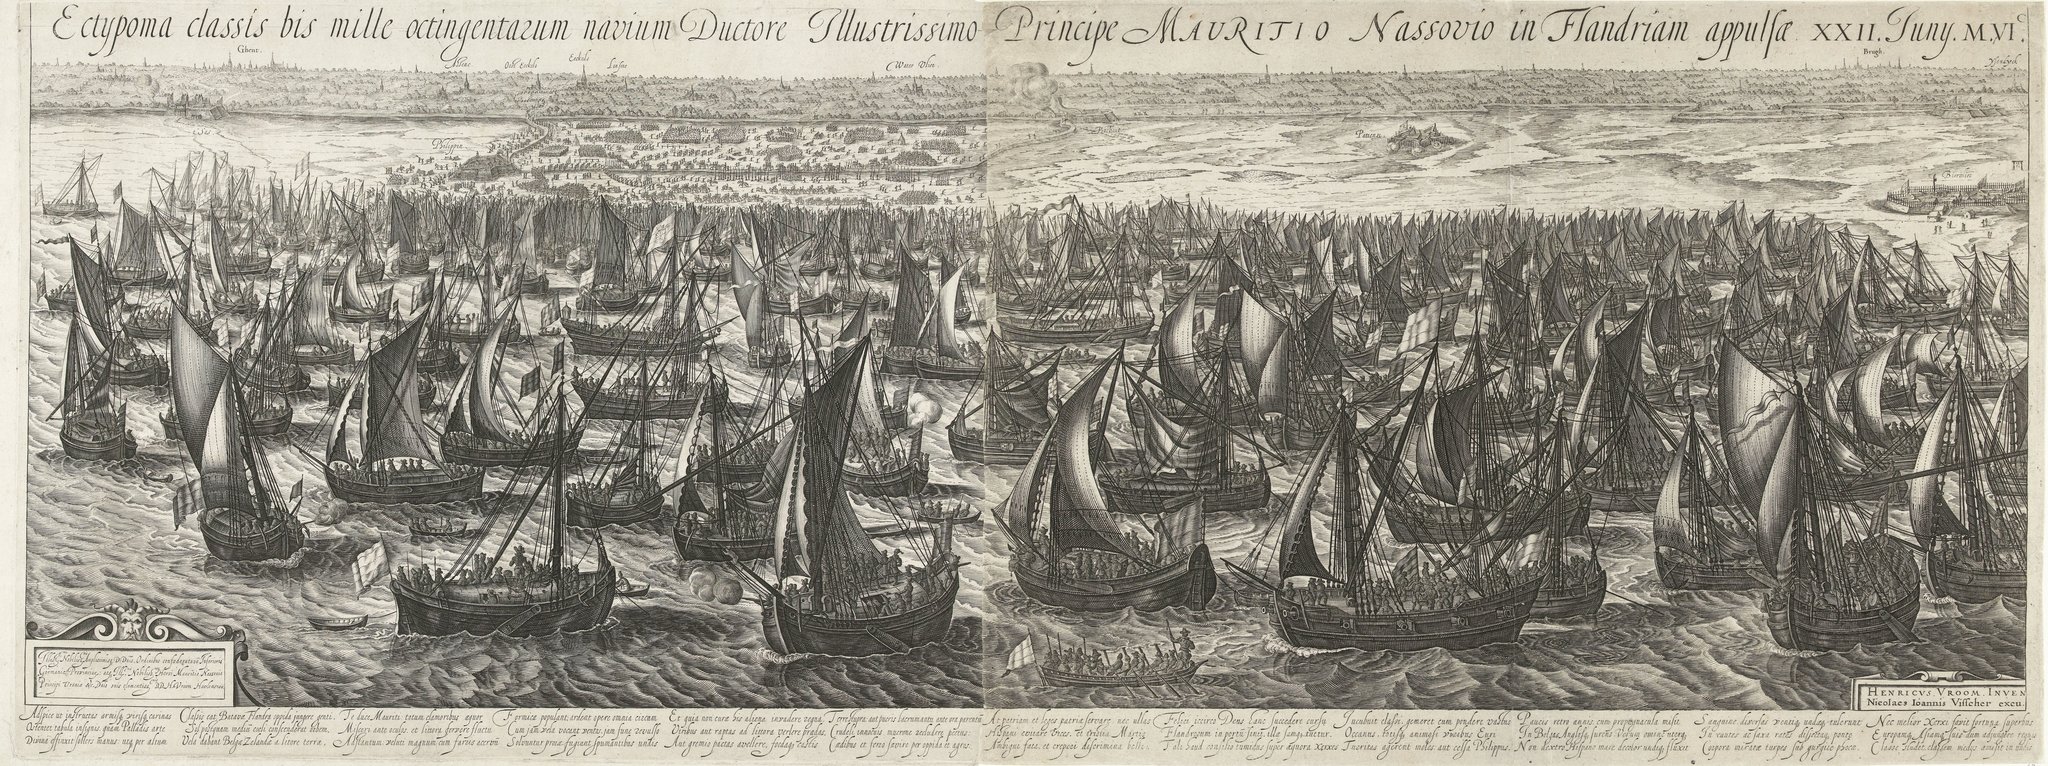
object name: print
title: De vlootlanding bij Philippine, 1600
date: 1600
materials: paper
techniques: engraving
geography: northern netherlands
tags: maurice (prince of orange), troop movements, transportation (+ sailing-ships)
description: De vlootlanding bij Philippine. De Staatse vloot van Maurits voor Philippine waar manschappen aan boord worden genomen, 22 juni 1600. Tocht naar Oostende van het Staatse leger, 19-27 juni, 1600. Linksonder een cartouche met de opdracht aan prins Maurits. Rechtsonder een cartouche met de namen van de inventor en uitgever. Met onderschrift van 12 verzen van elk 3 regels in het Latijn. Gehele voorstelling gedrukt op 2 aparte bladen.